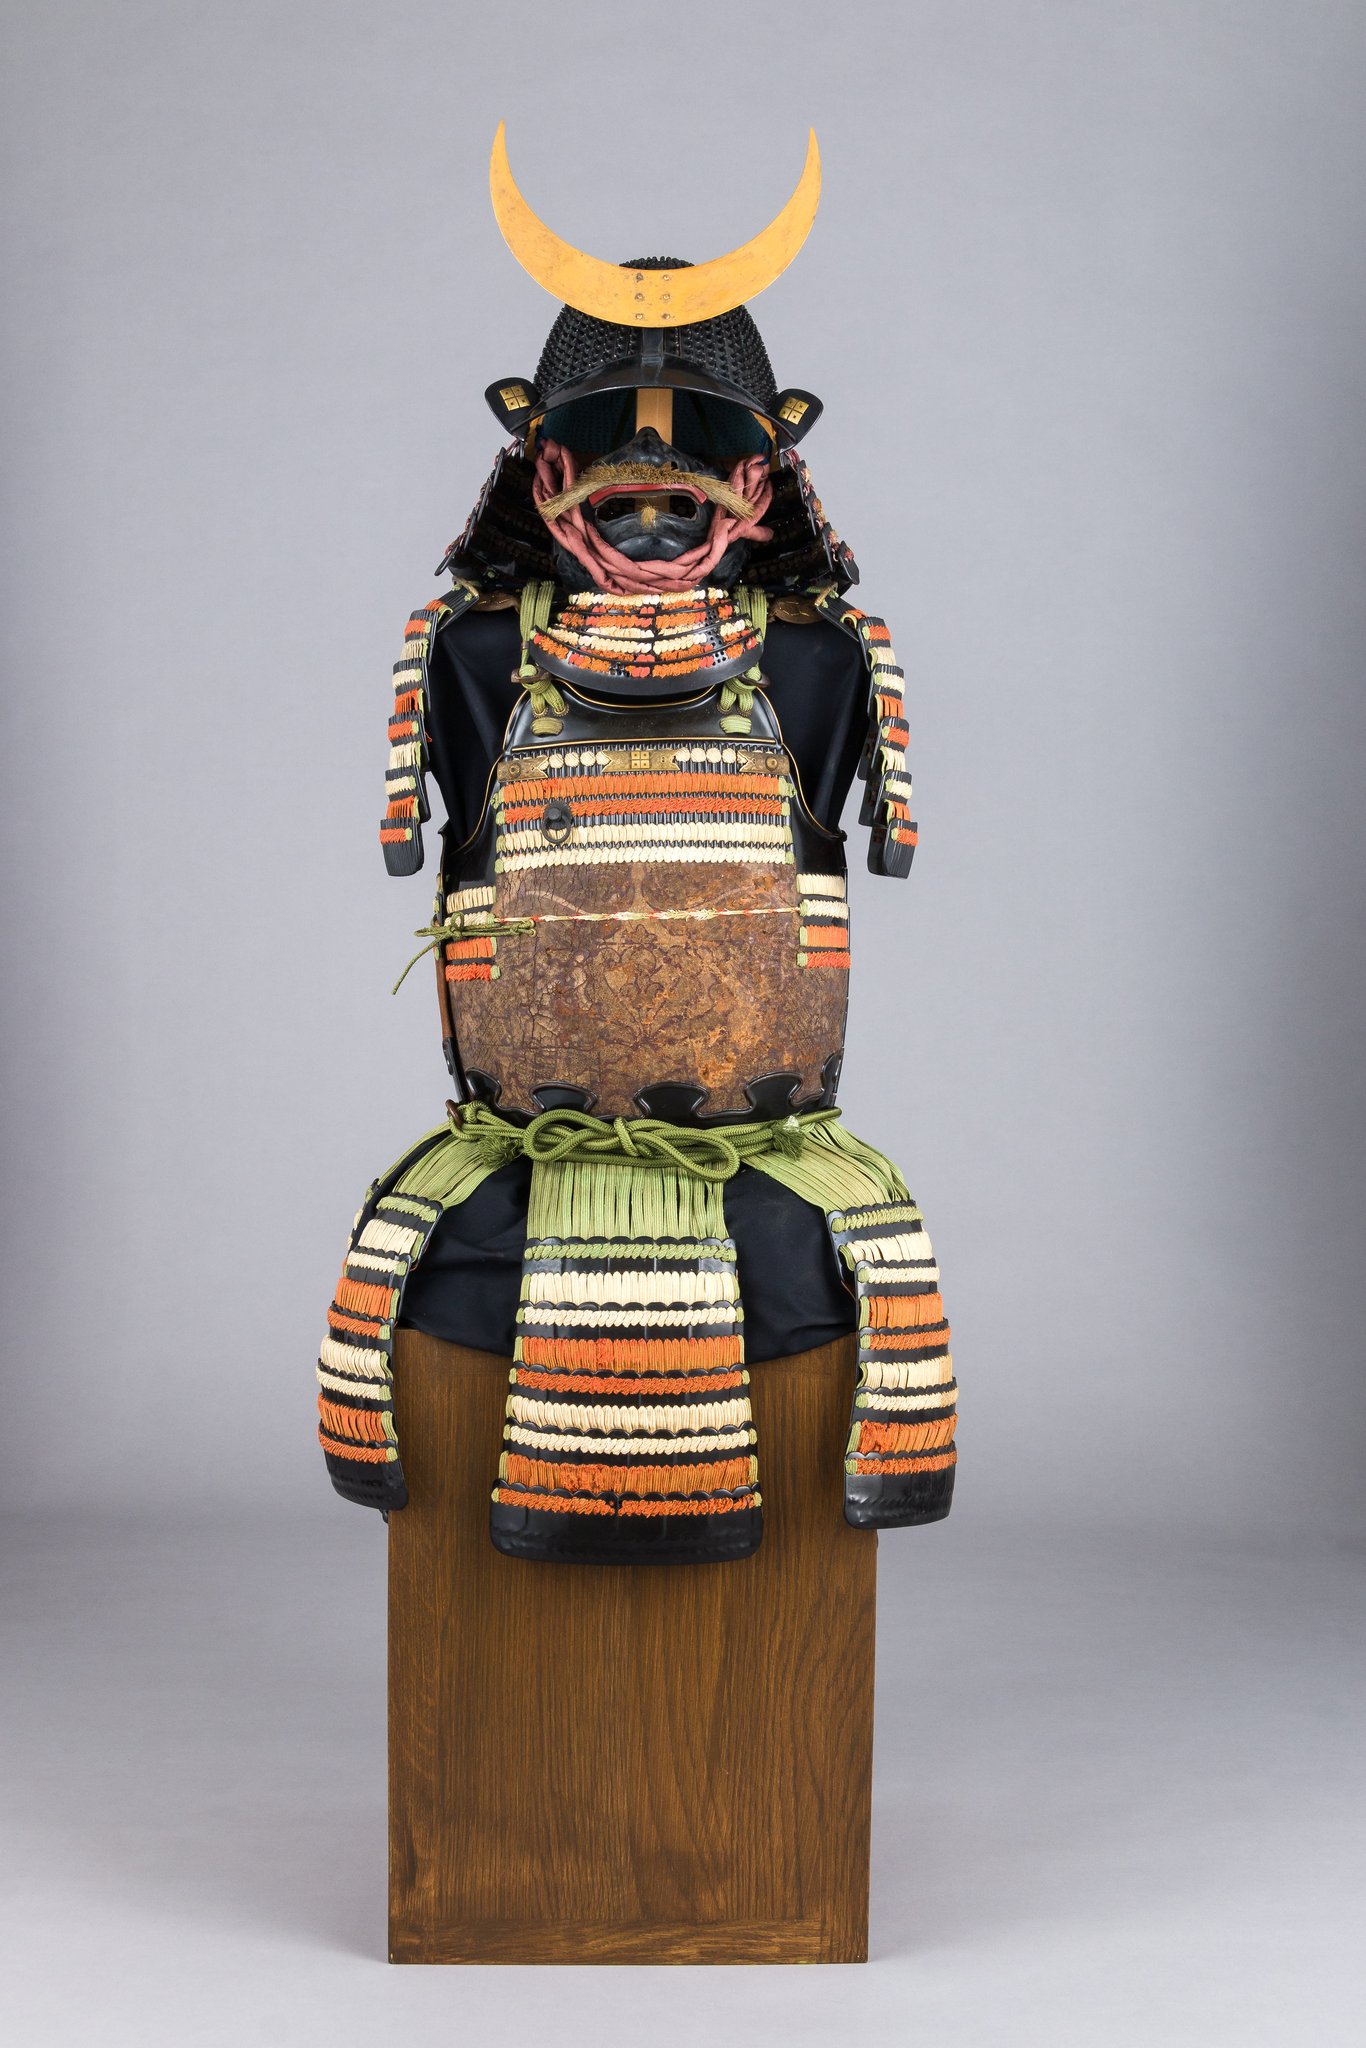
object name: armor i gusoku i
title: Armor (Gusoku)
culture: japanese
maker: hiromichi miura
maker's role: restorer/conservator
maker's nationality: japanese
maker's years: 1938-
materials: copper, gold alloy, felt, gold, hair, iron, lacquer, leather, linen, silk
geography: japan